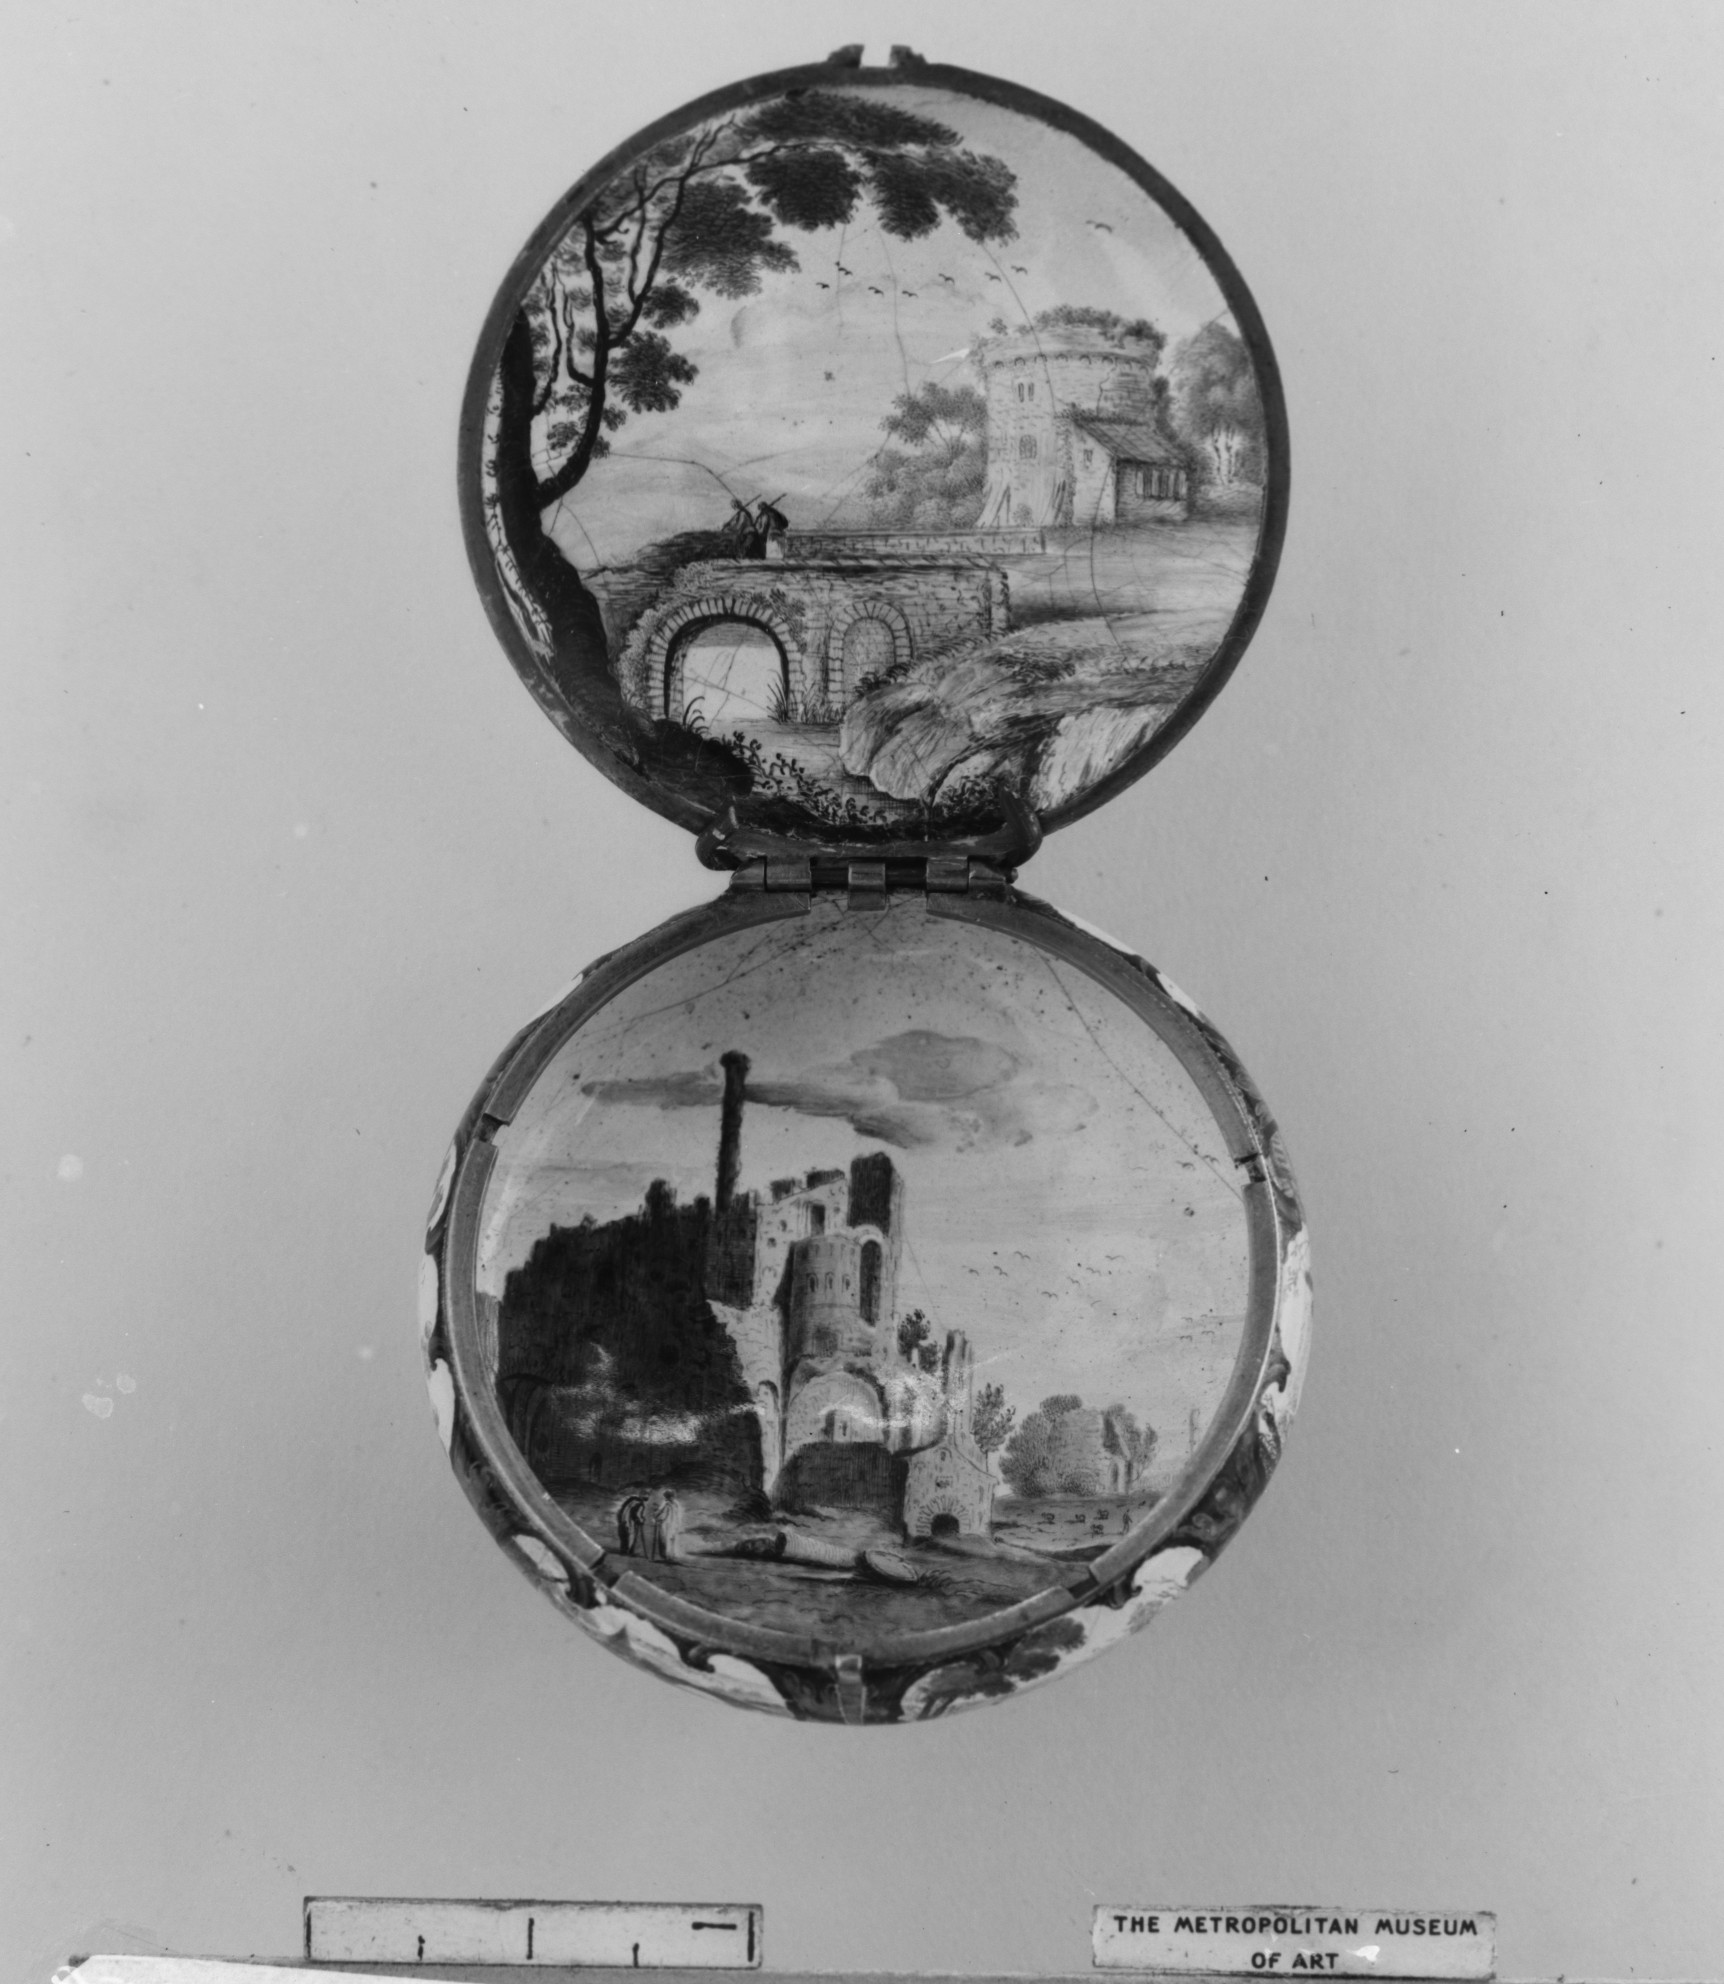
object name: watch case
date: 1601-1700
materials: enamel, metal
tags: ruins